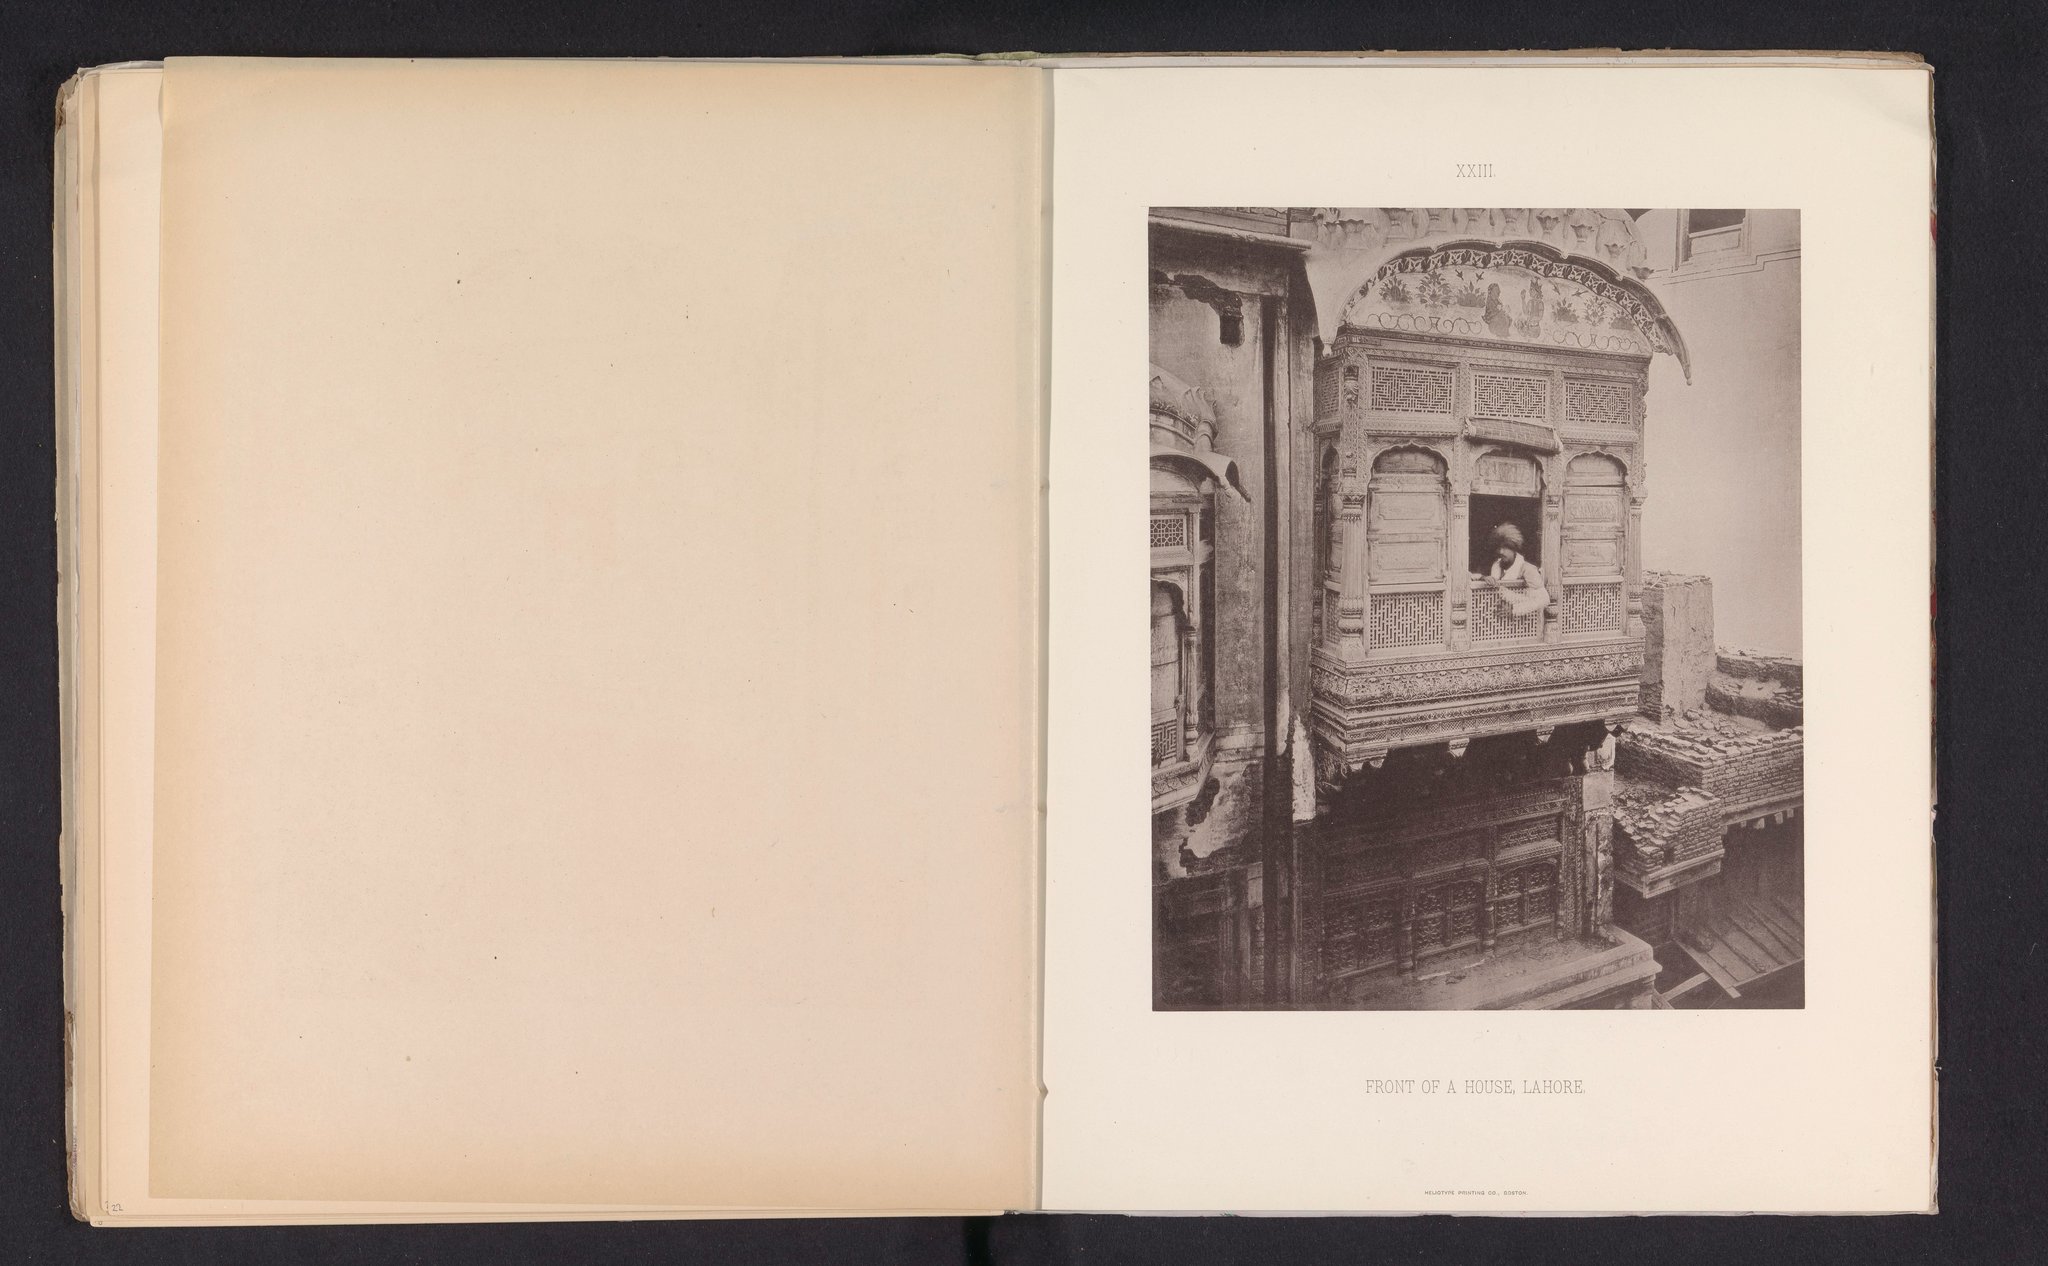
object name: photomechanical print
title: Façade of a house with a man in a window frame in Lahore, Punjab, Pakistan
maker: Anonymous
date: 1875-1885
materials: paper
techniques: photoaquatint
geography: boston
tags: urban housing, human figure at (open) window, seen from outside - aa - feigned window, façade (of house or building)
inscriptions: title: ‘FRONT OF A HOUSE, LAHORE.’, number: ‘XXIII.’